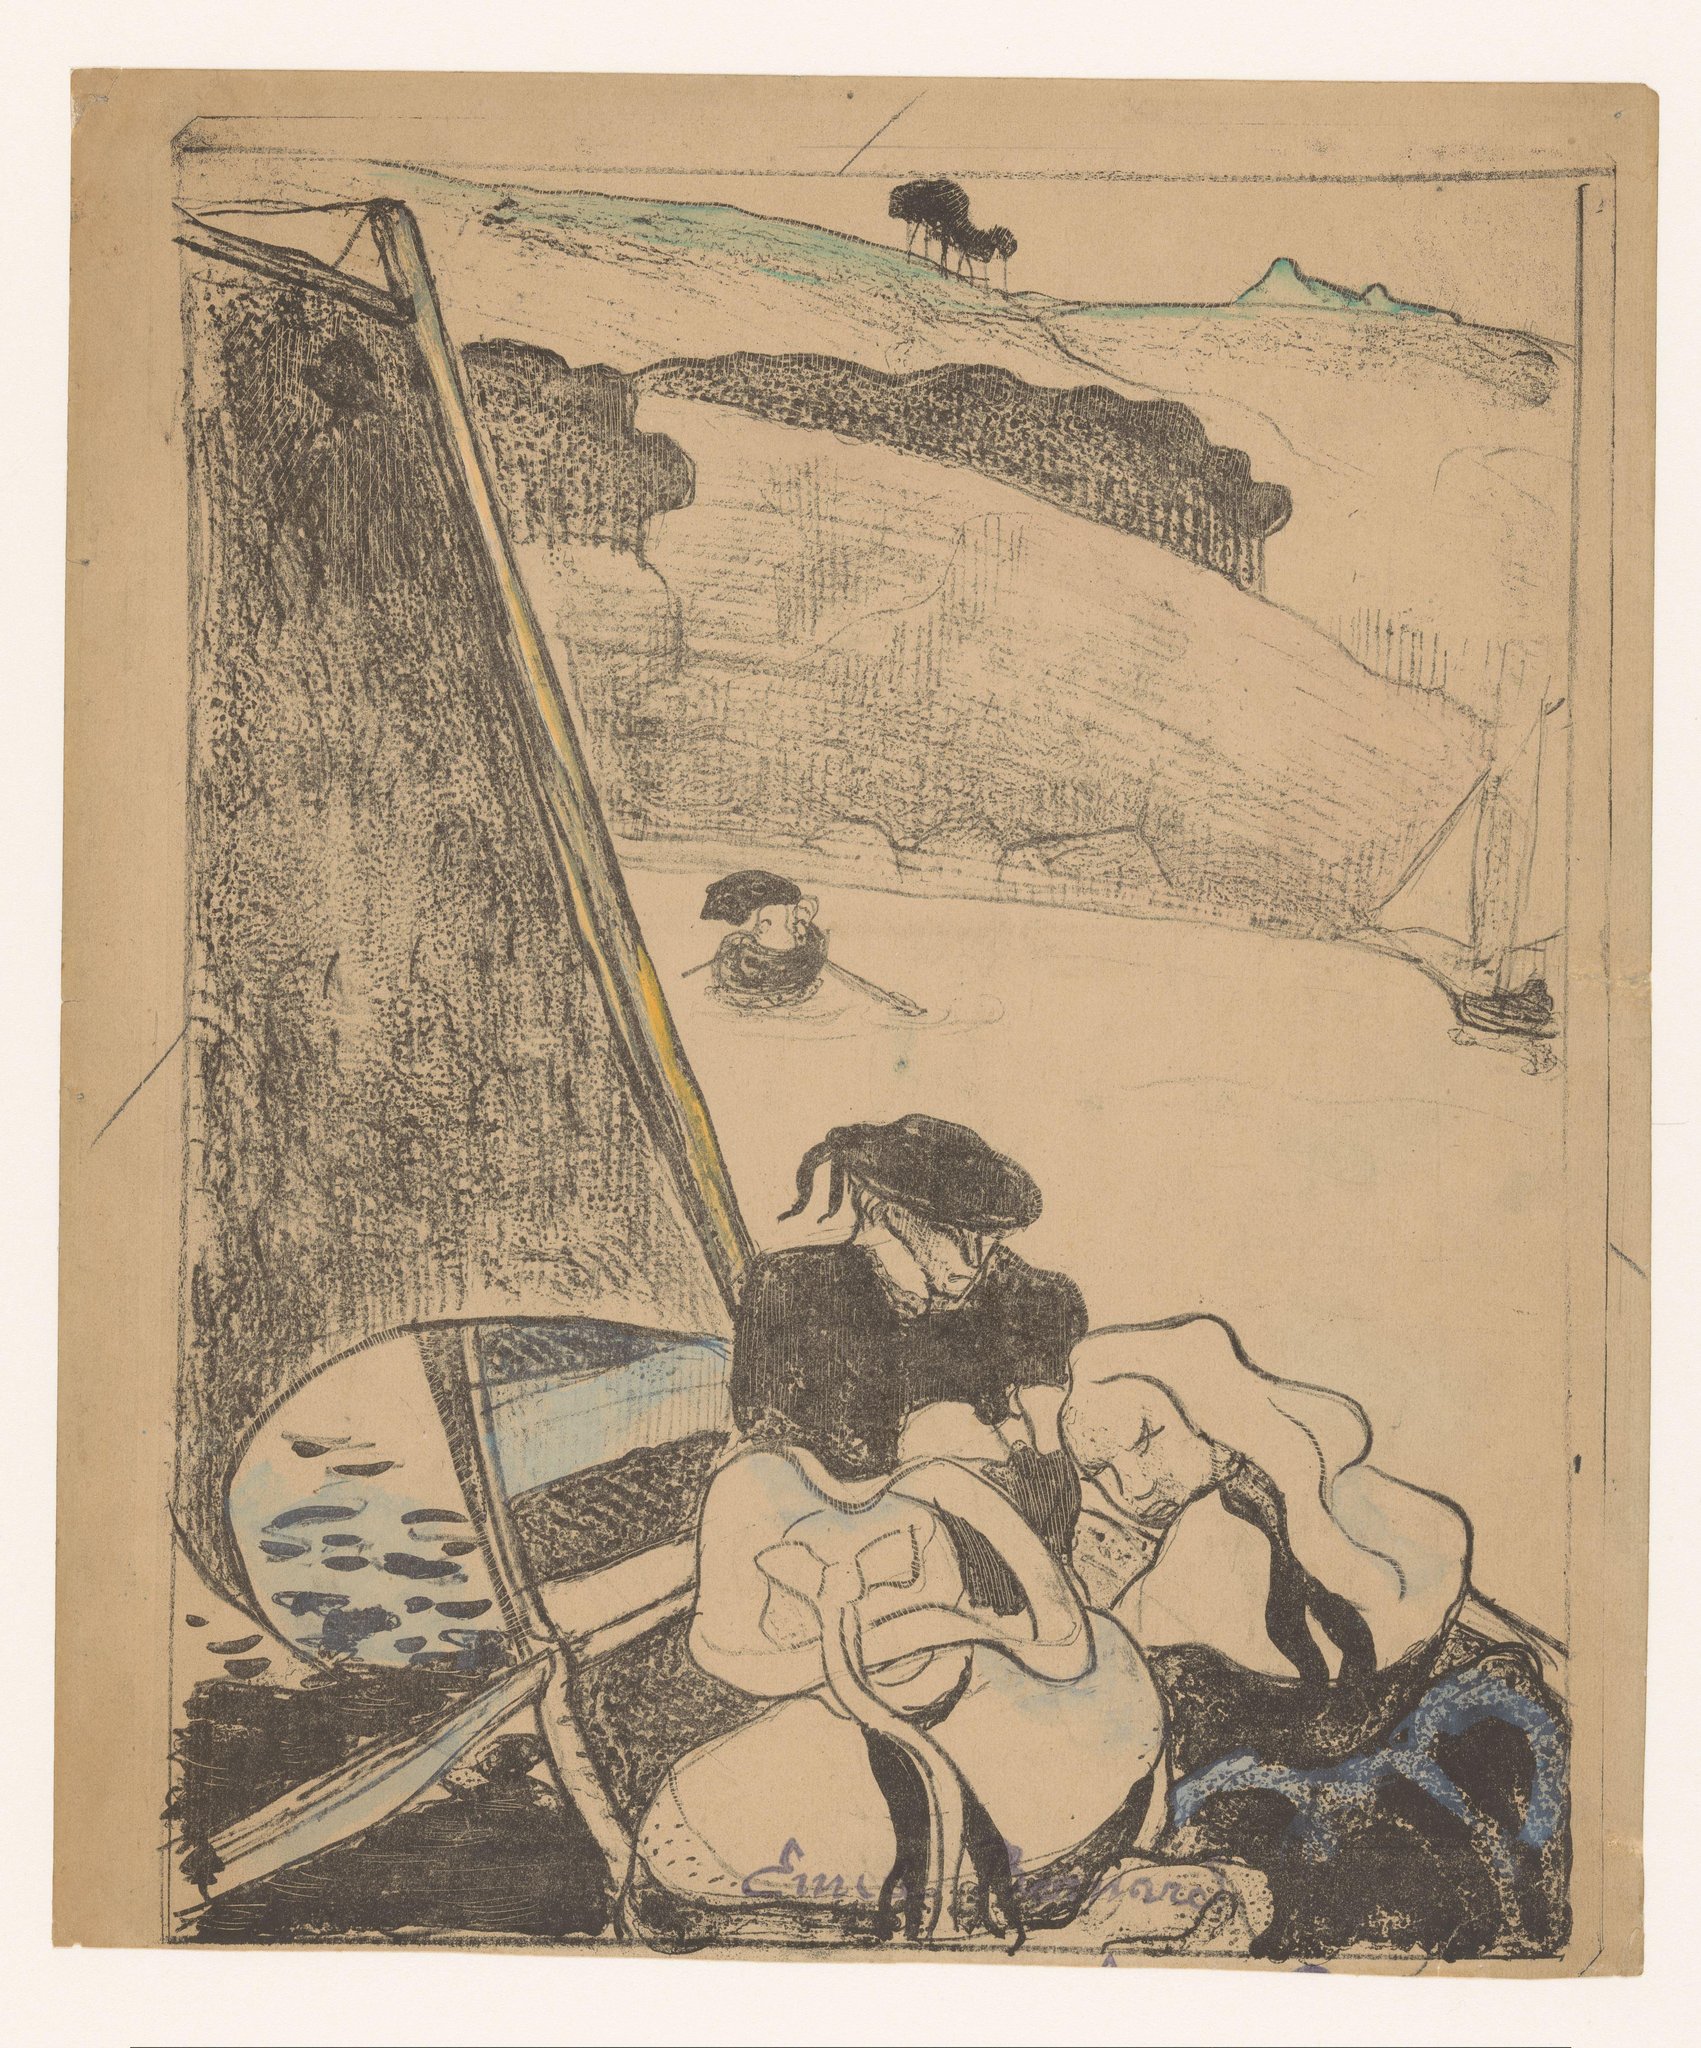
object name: print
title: Le retour du pardon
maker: émile bernard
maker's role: print maker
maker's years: 1868-1941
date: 1889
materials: paper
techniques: hand coloring, lithography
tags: fashion, clothing, river, rowing-boat, canoe, etc.